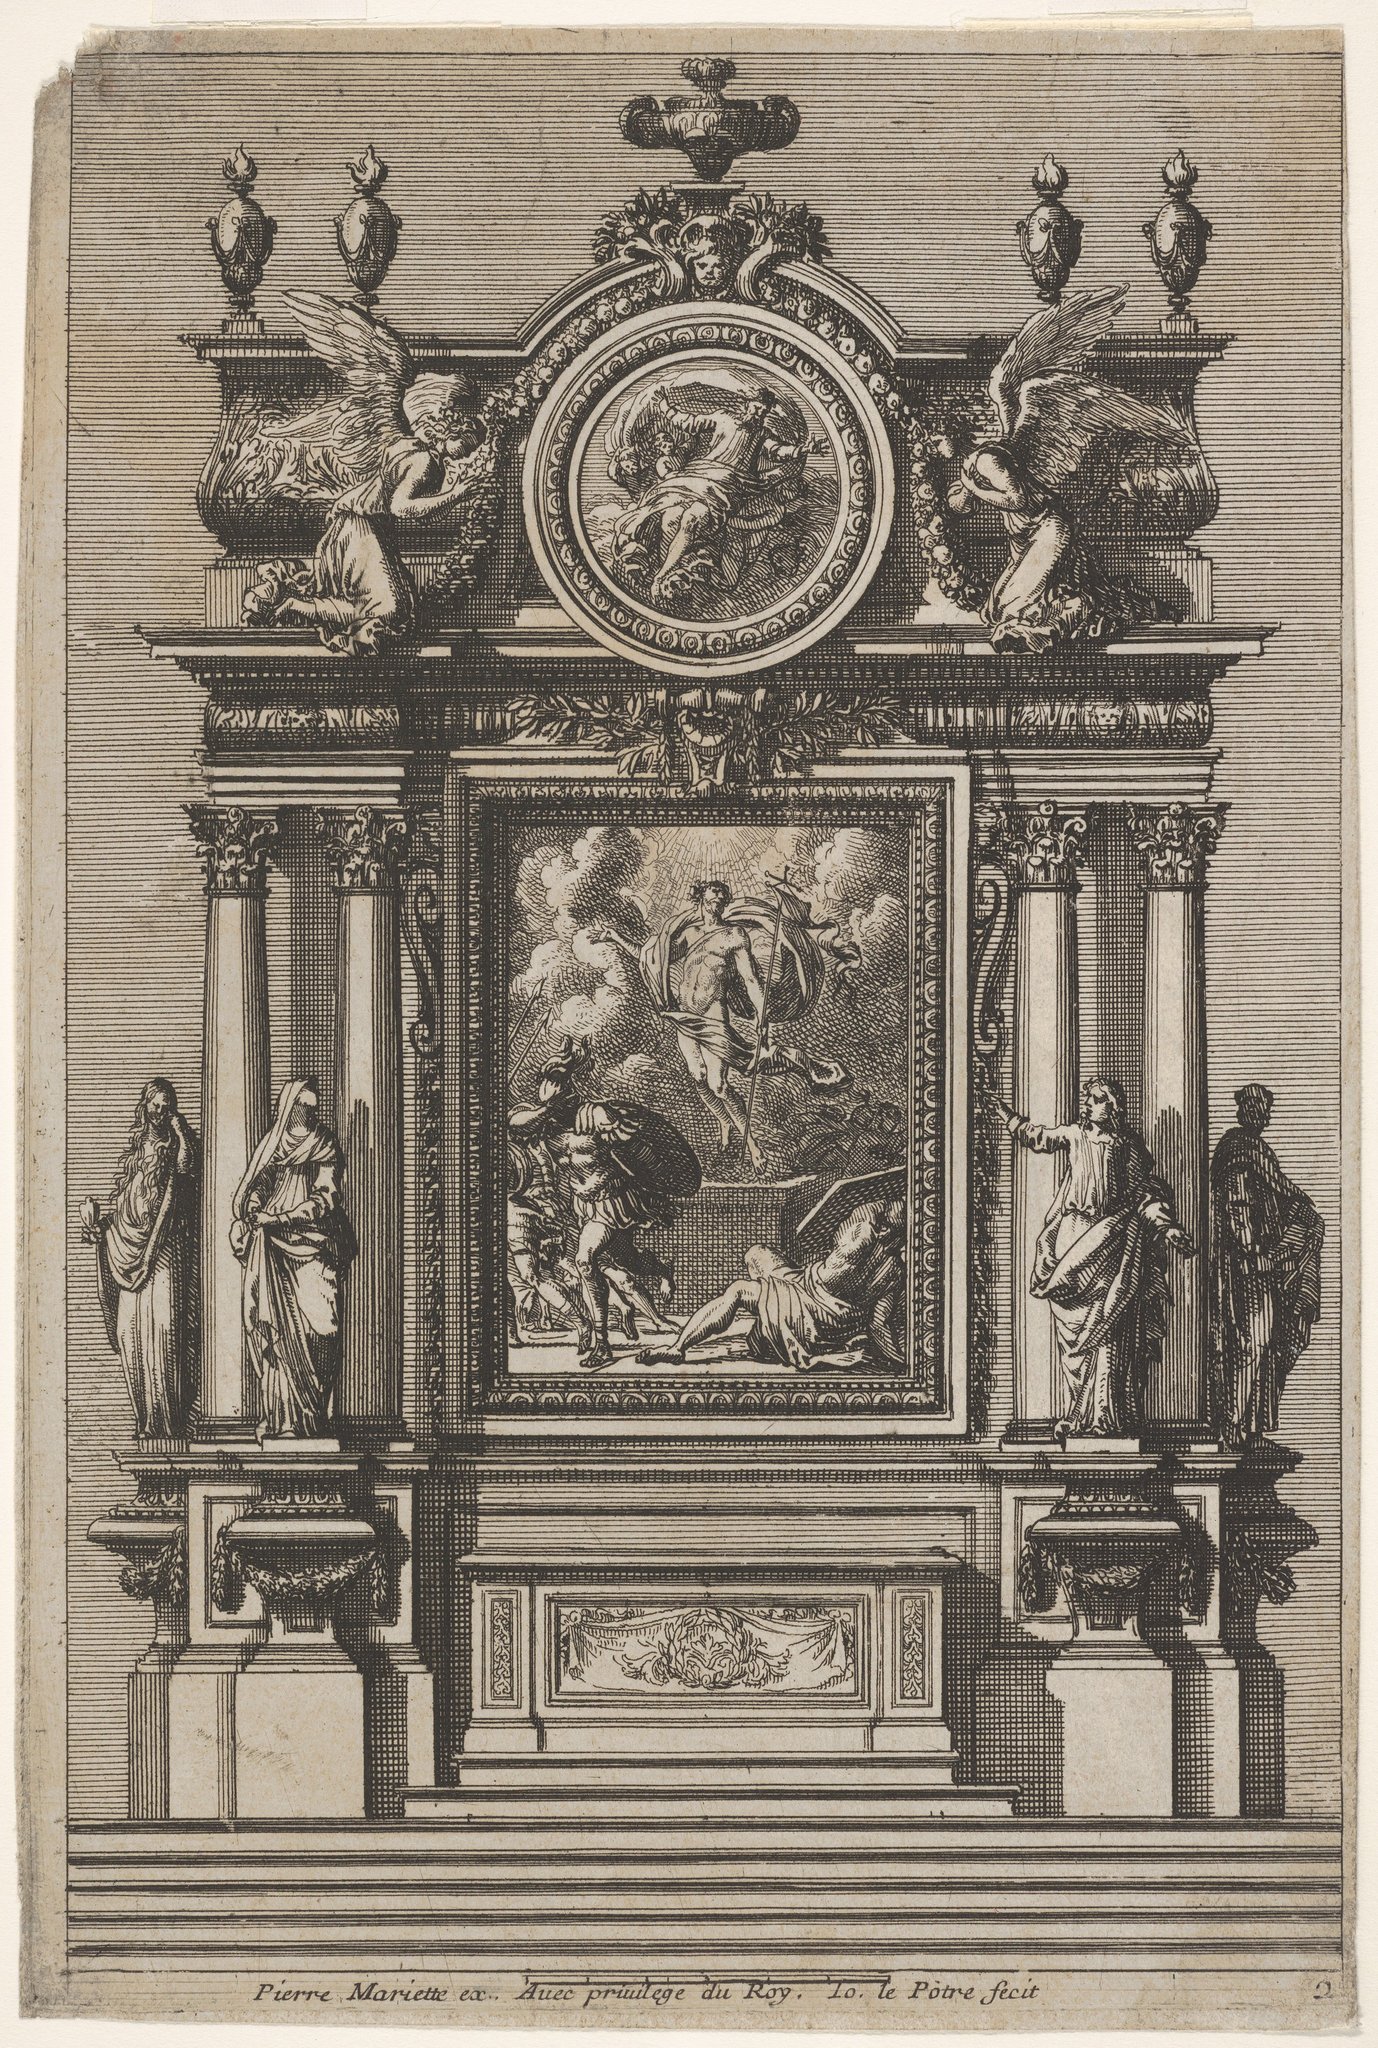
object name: print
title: Altar with the Resurrection of Christ, plate 2 from "Nouveaux dessins d'autels à la romaine"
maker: jean le pautre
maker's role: artist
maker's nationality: french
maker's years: 1618-1682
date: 1640-1682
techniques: etching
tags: architecture,altars,angels,christ